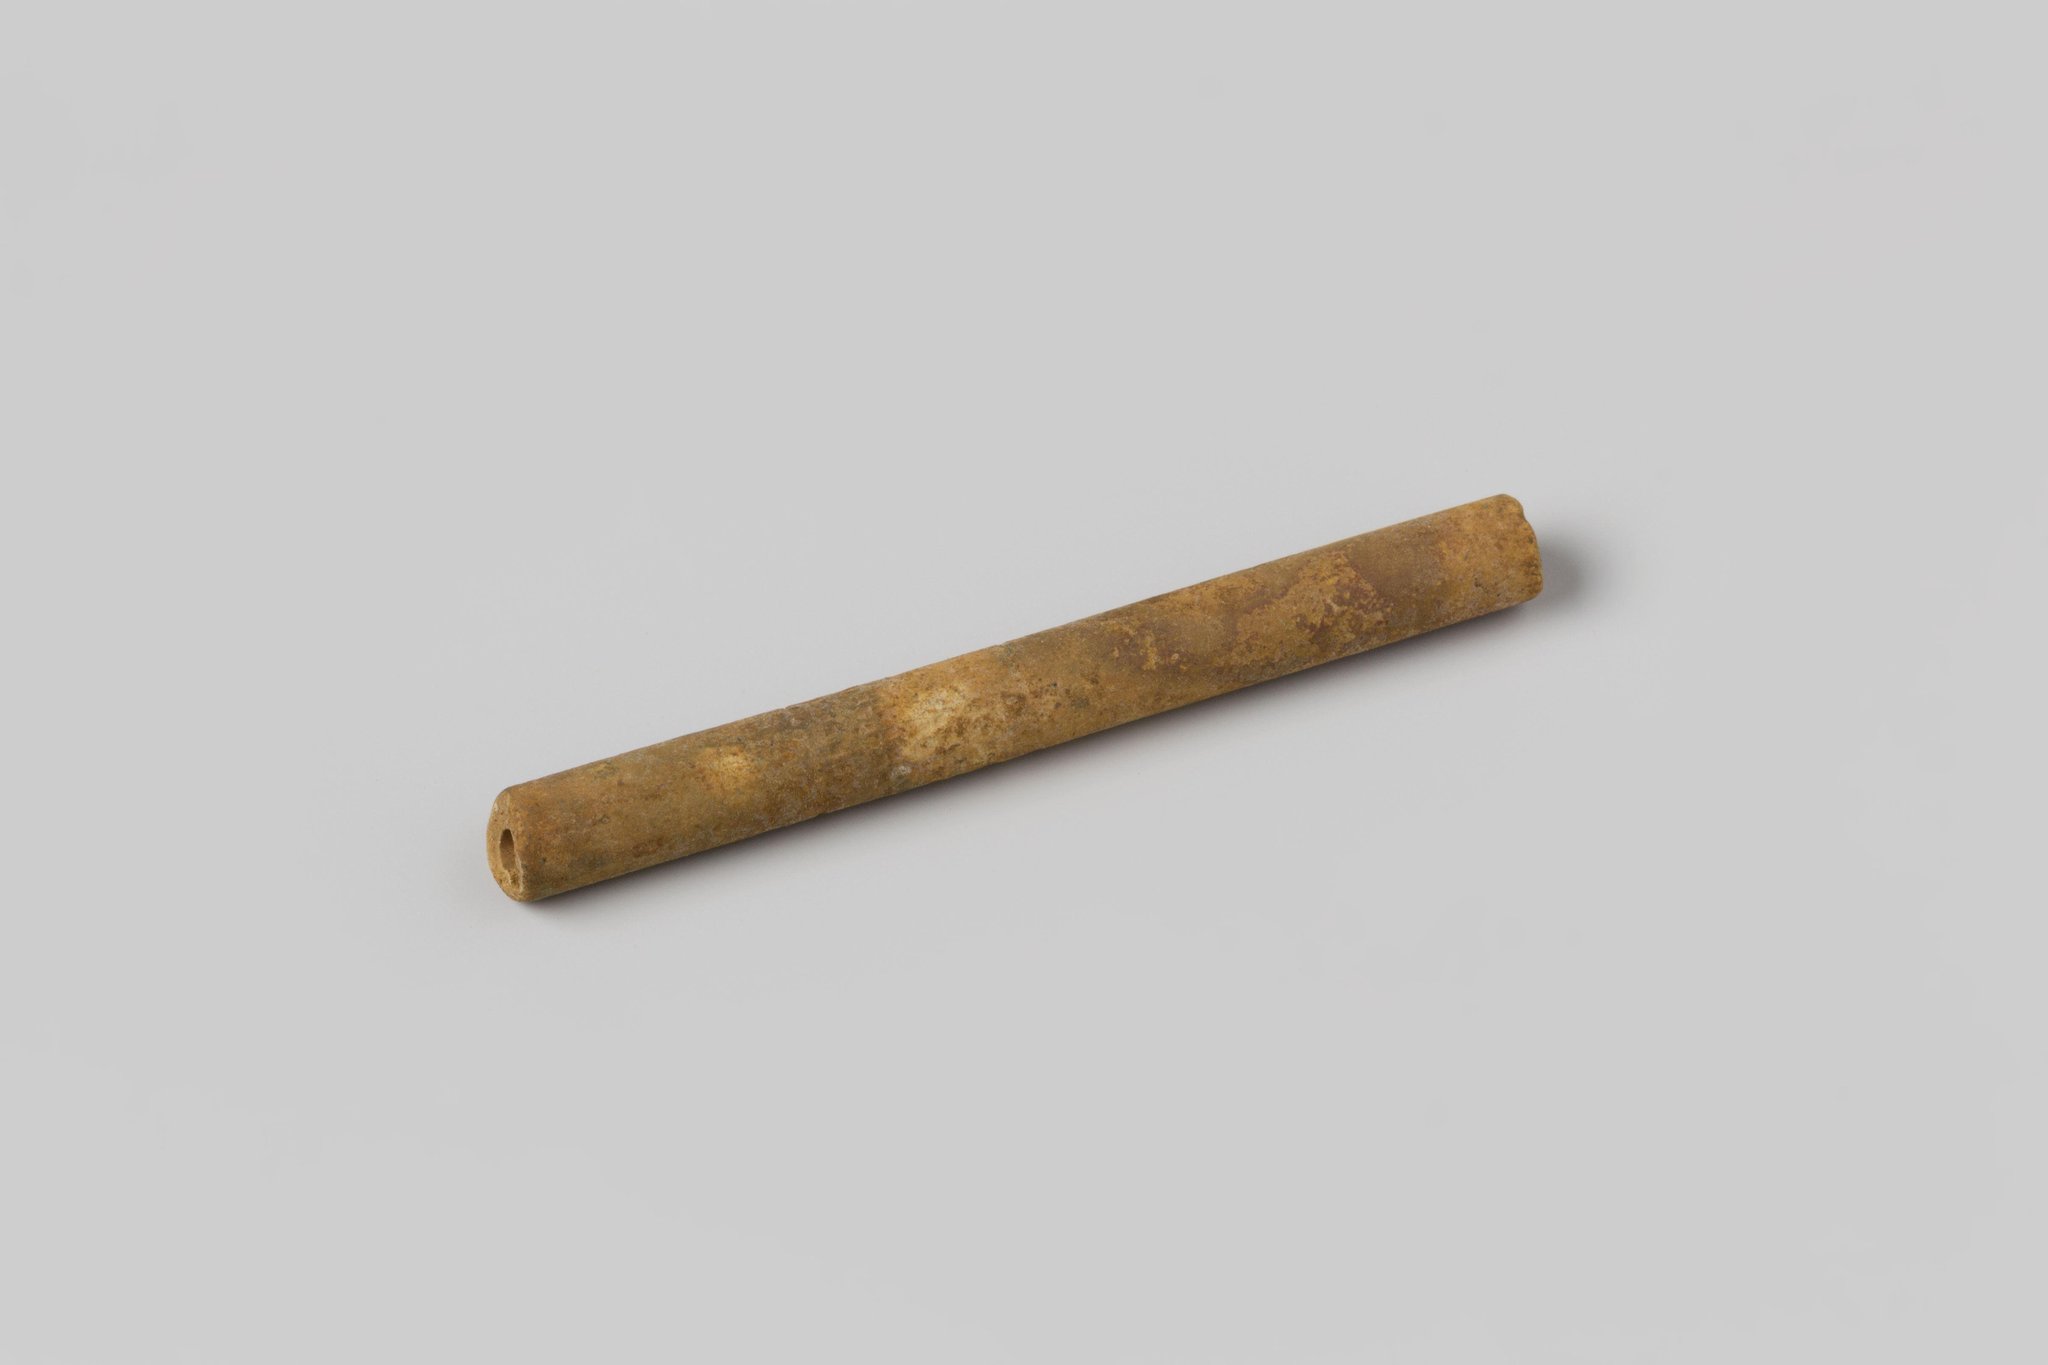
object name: pipe stem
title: Fragment oijpesteel uit het wrak van de Oost-Indiëvaarder Hollandia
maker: Anonymous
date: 1700-1743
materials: clay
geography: netherlands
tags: verenigde oostindische compagnie, hollandia (schip), annet